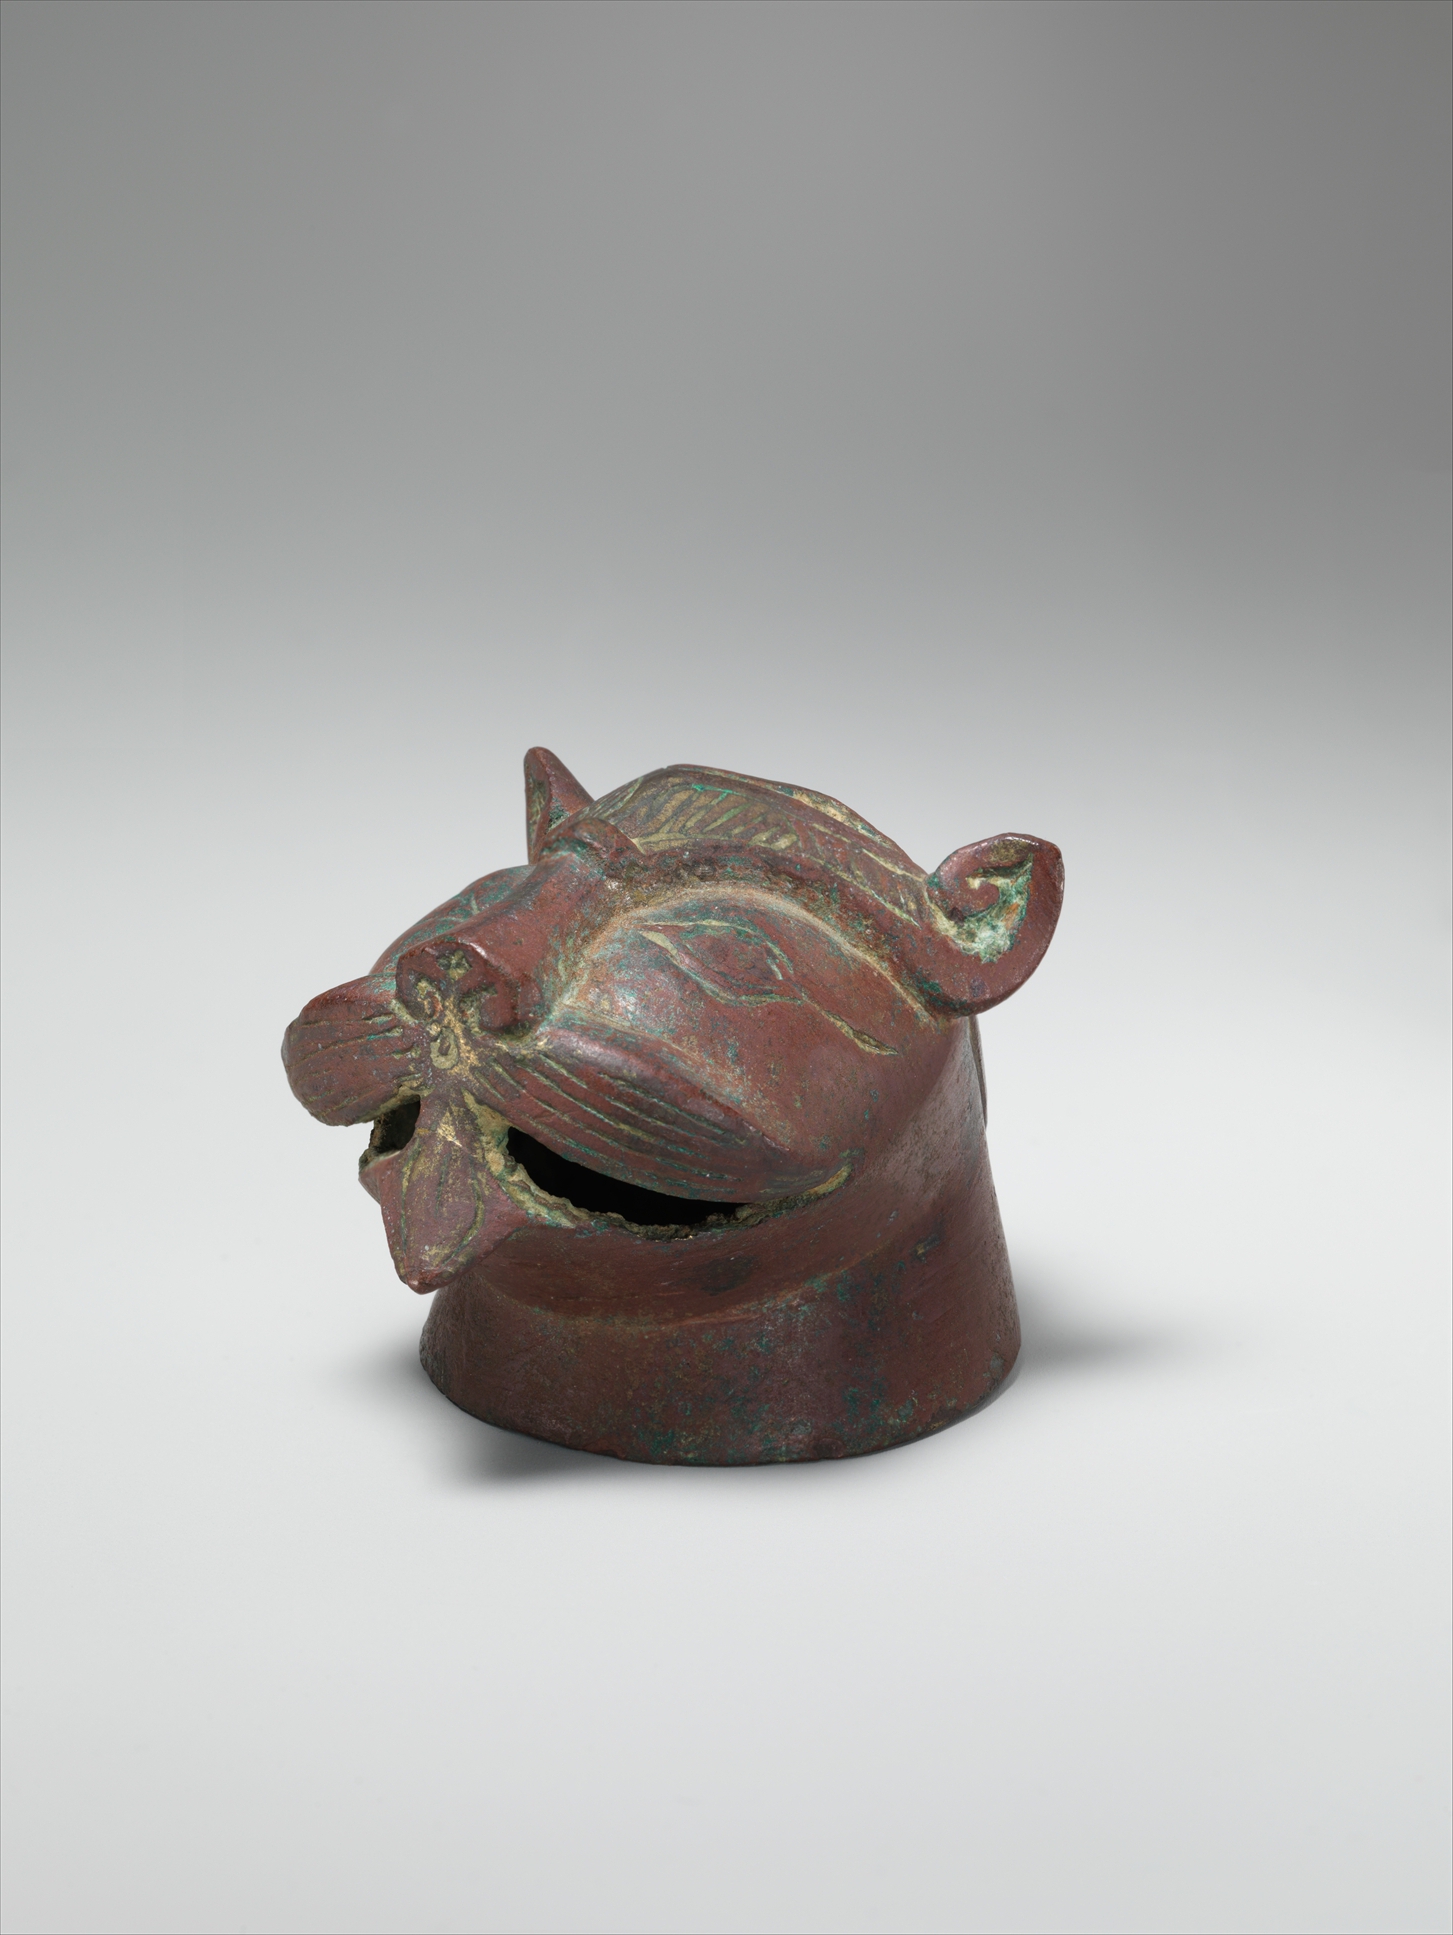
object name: incense burner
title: Incense Burner in the Shape of a Lion's Head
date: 1101-1233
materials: bronze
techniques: casting, engraving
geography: iran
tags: lions